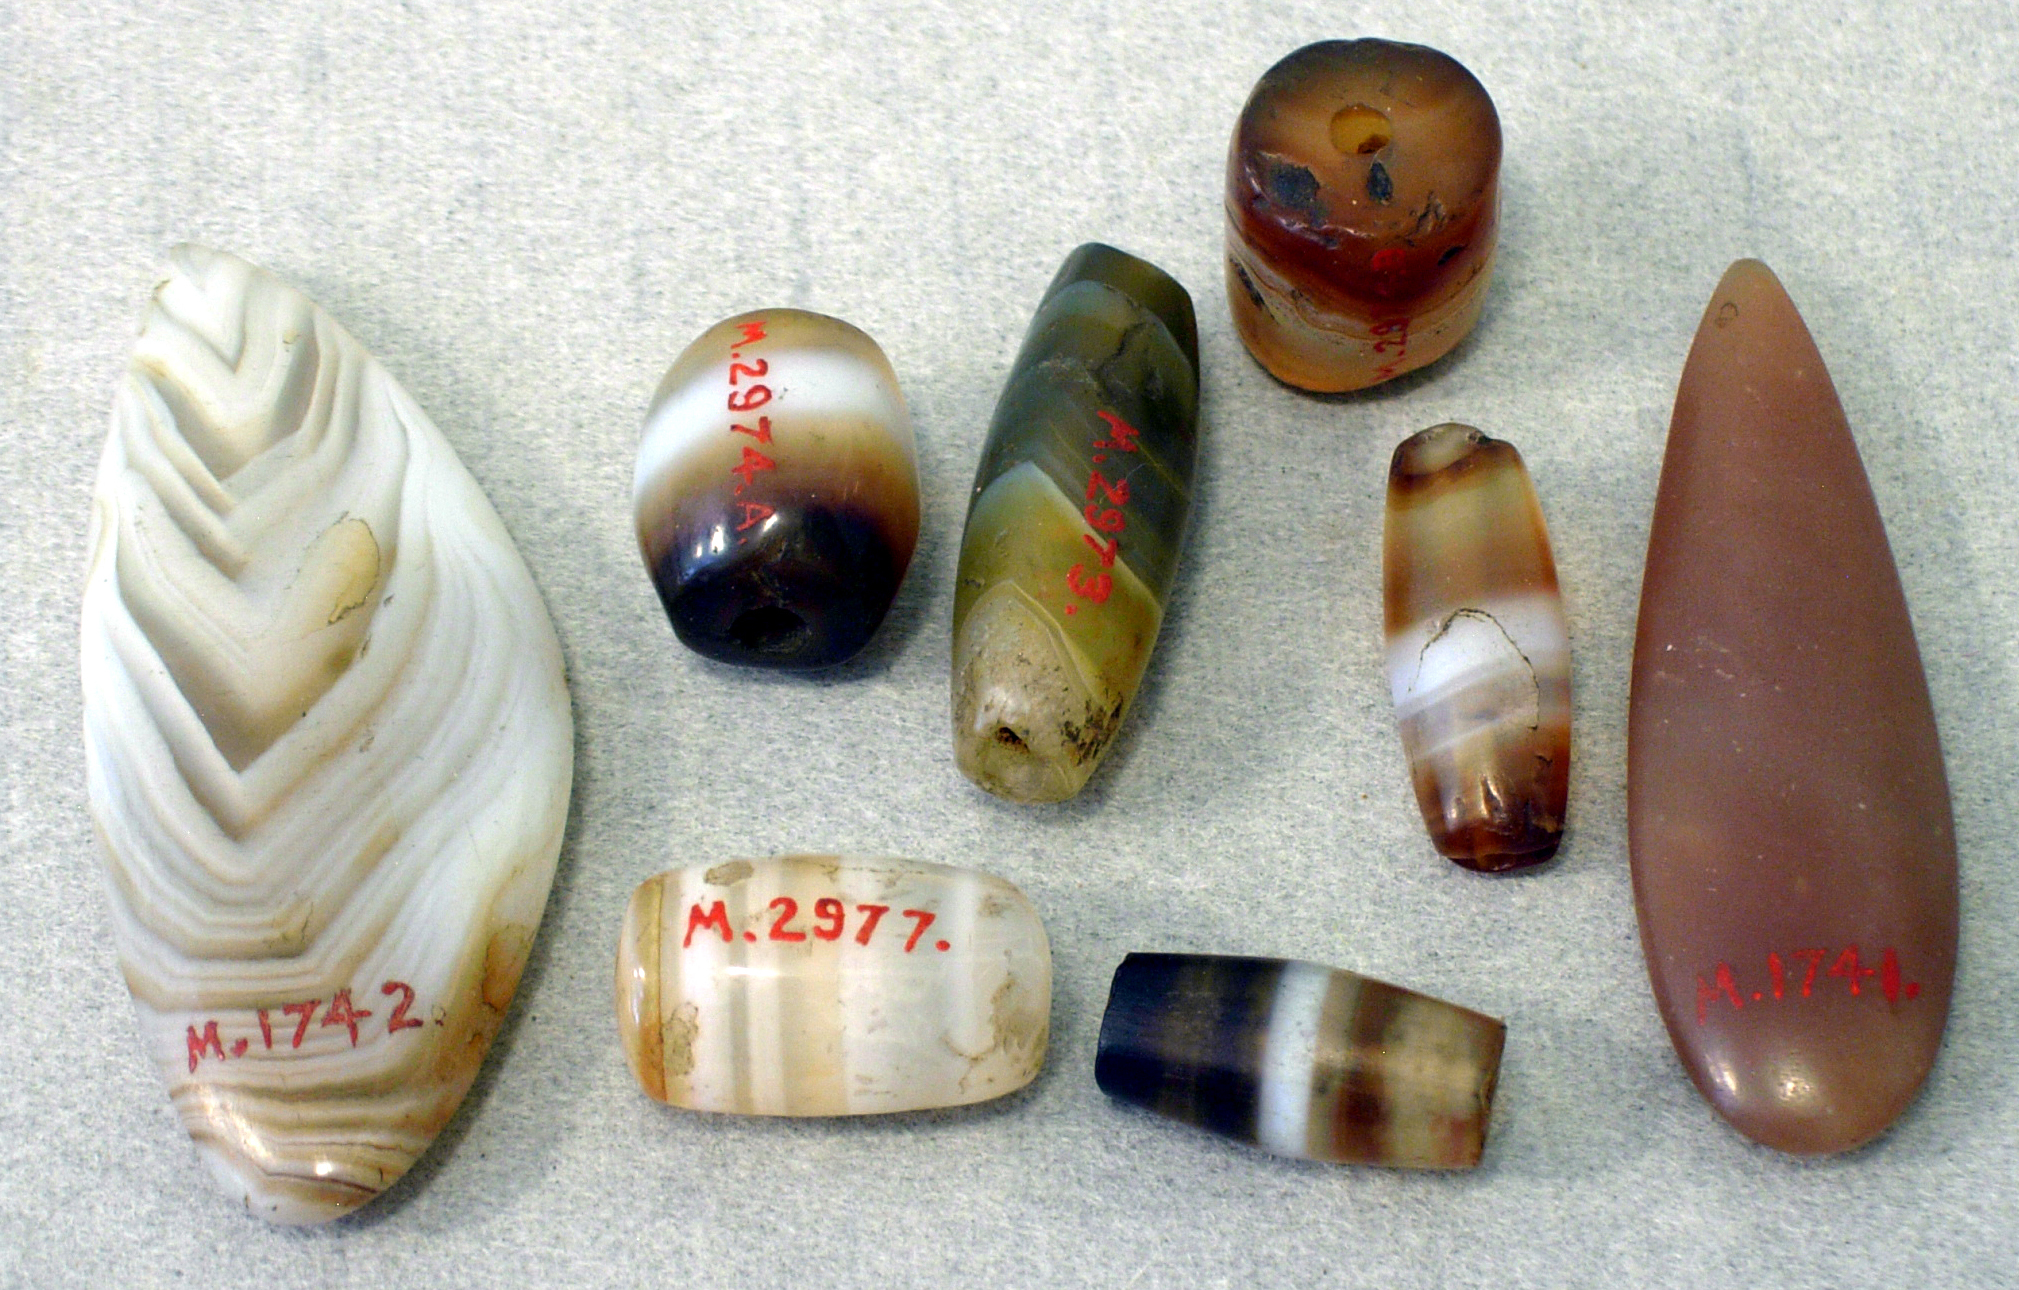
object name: bead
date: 801-1900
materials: stone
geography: egypt